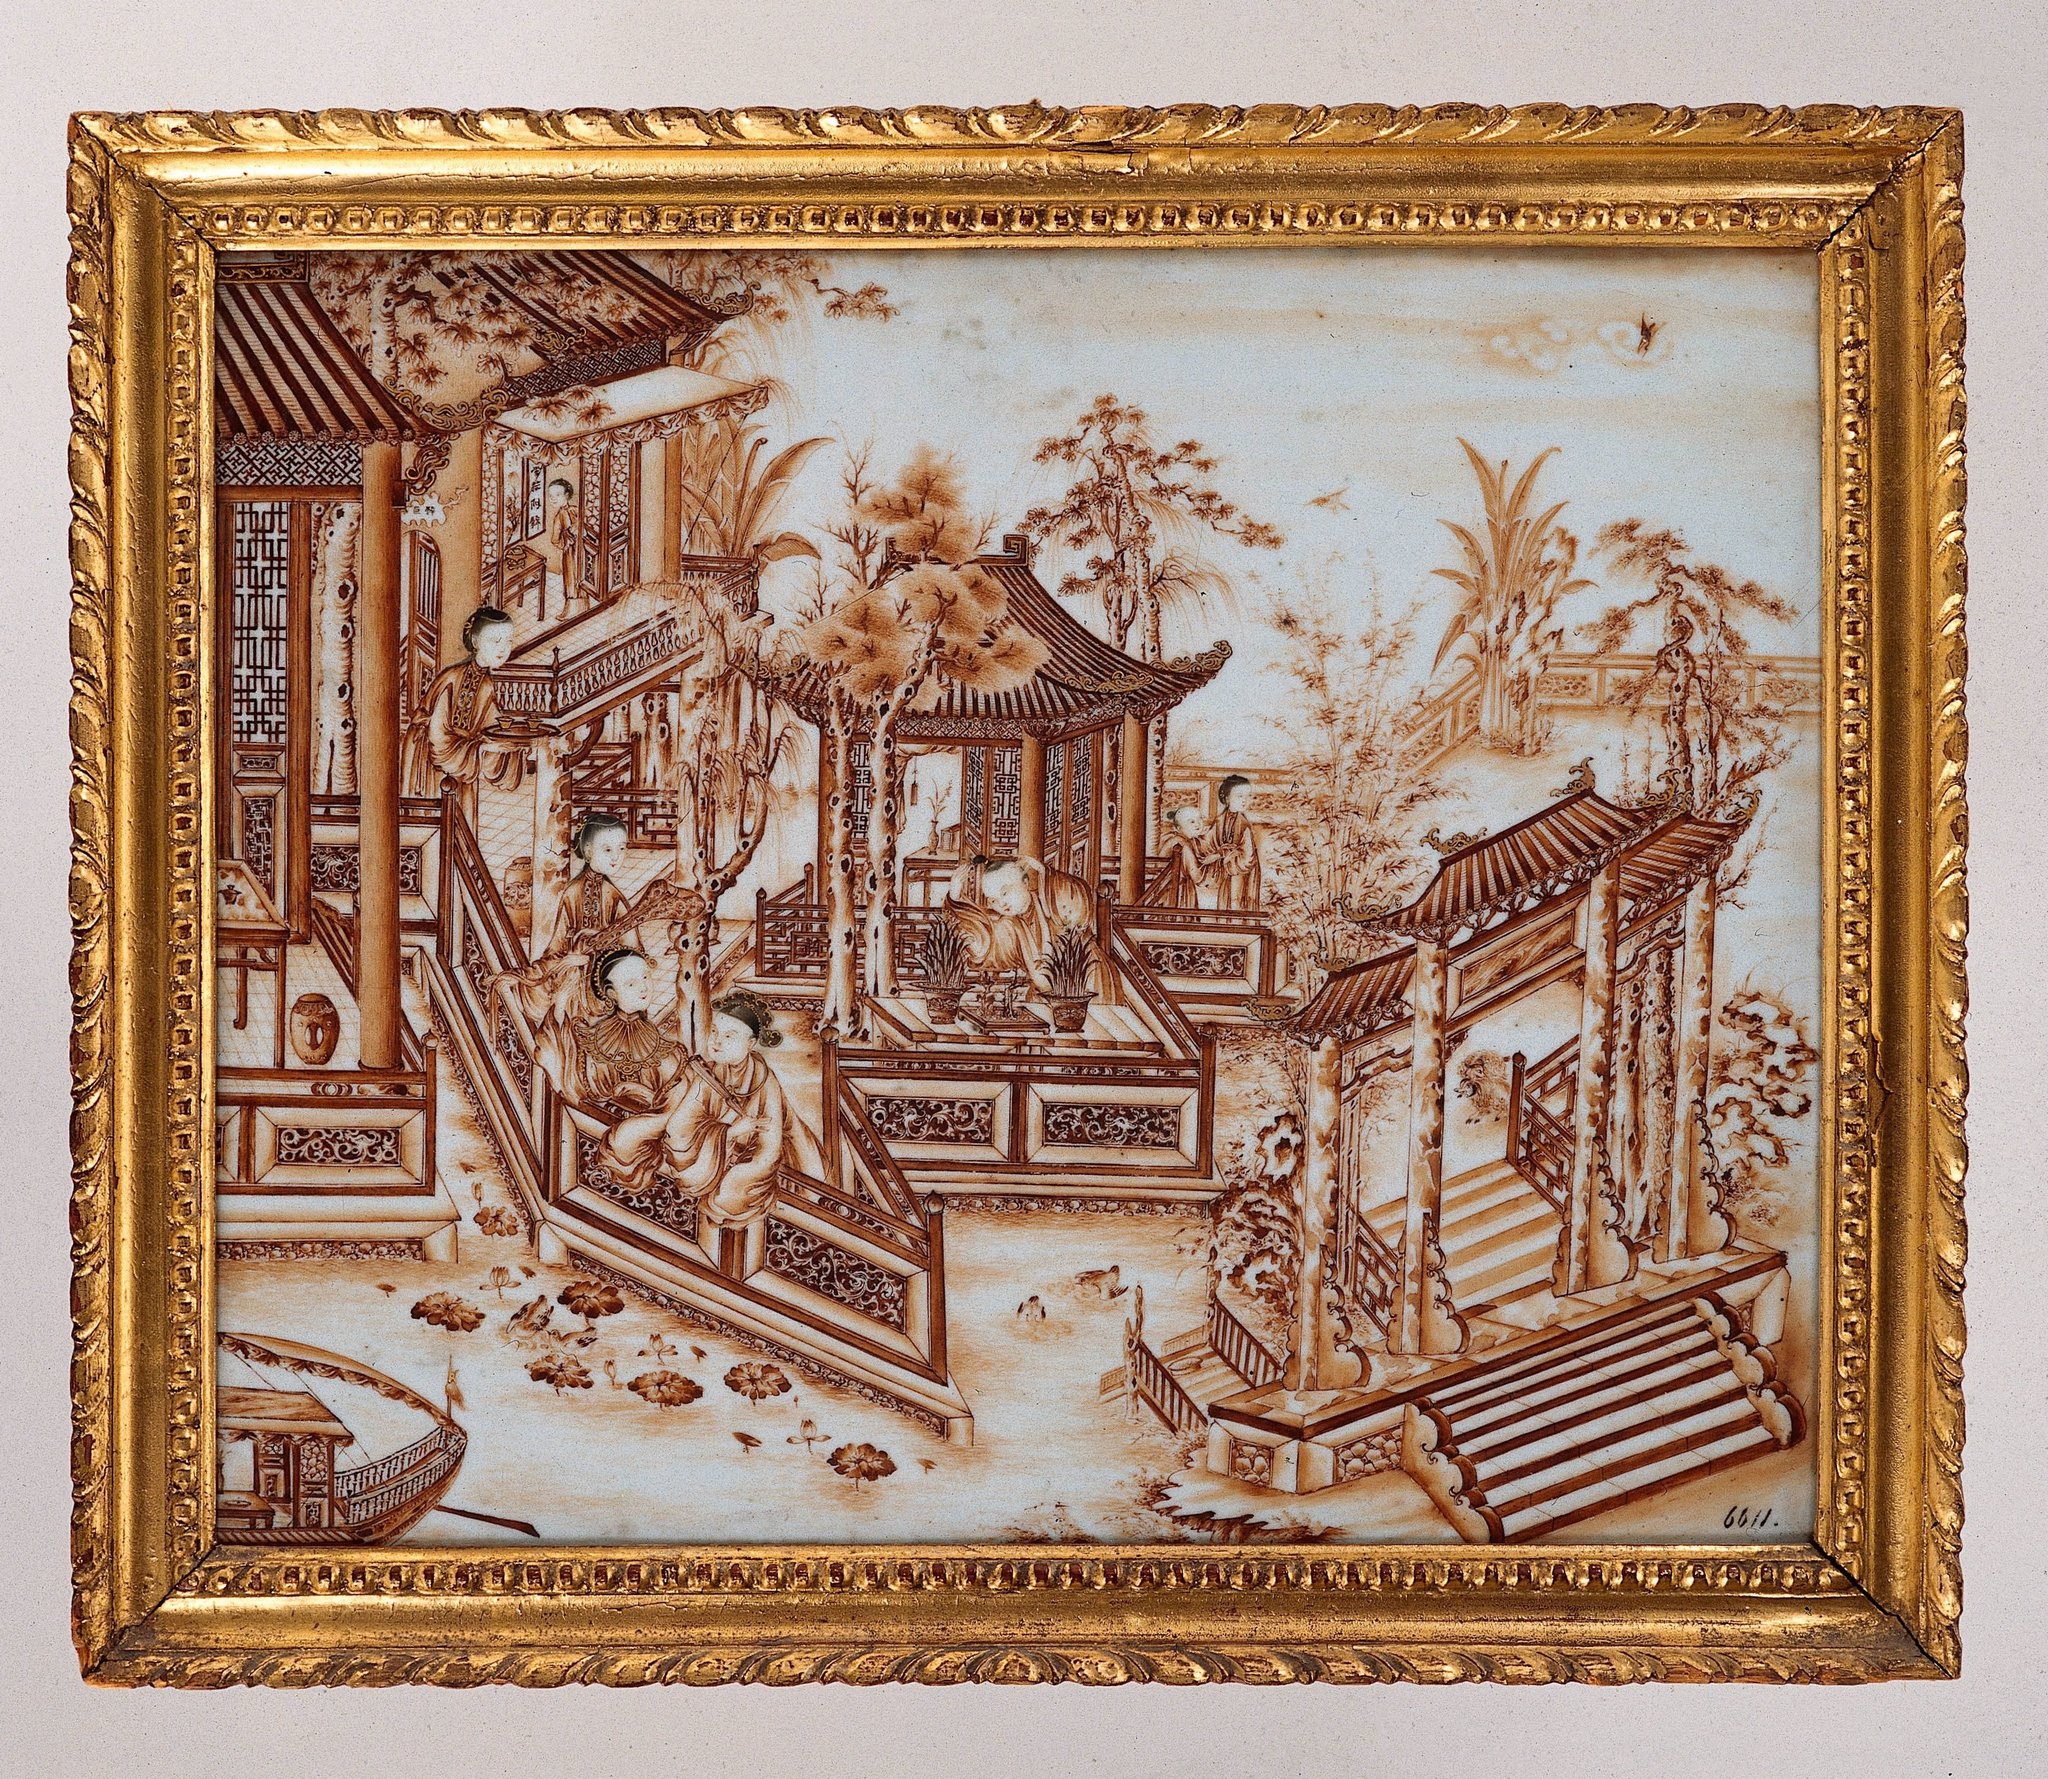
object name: plate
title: Panel with people in pavillions near a pond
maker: Anonymous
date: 1770-1775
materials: glaze, gold, paint, porcelain, wood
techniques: firing, forming, gilding, vitrification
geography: china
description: Plaque van porselein, beschilderd op het glazuur in sepia en goud. De voorstelling toont verschillende personen in paviljoens. Op de voorgrond een man en een vrouw leunend over de balustrade. De paviljoens worden omringd door een omheinde tuin aan de ene kant en een vijver met lotusplanten en een boot aan de andere kant. Originele vergulde lijst. Porselein met emailkleuren.